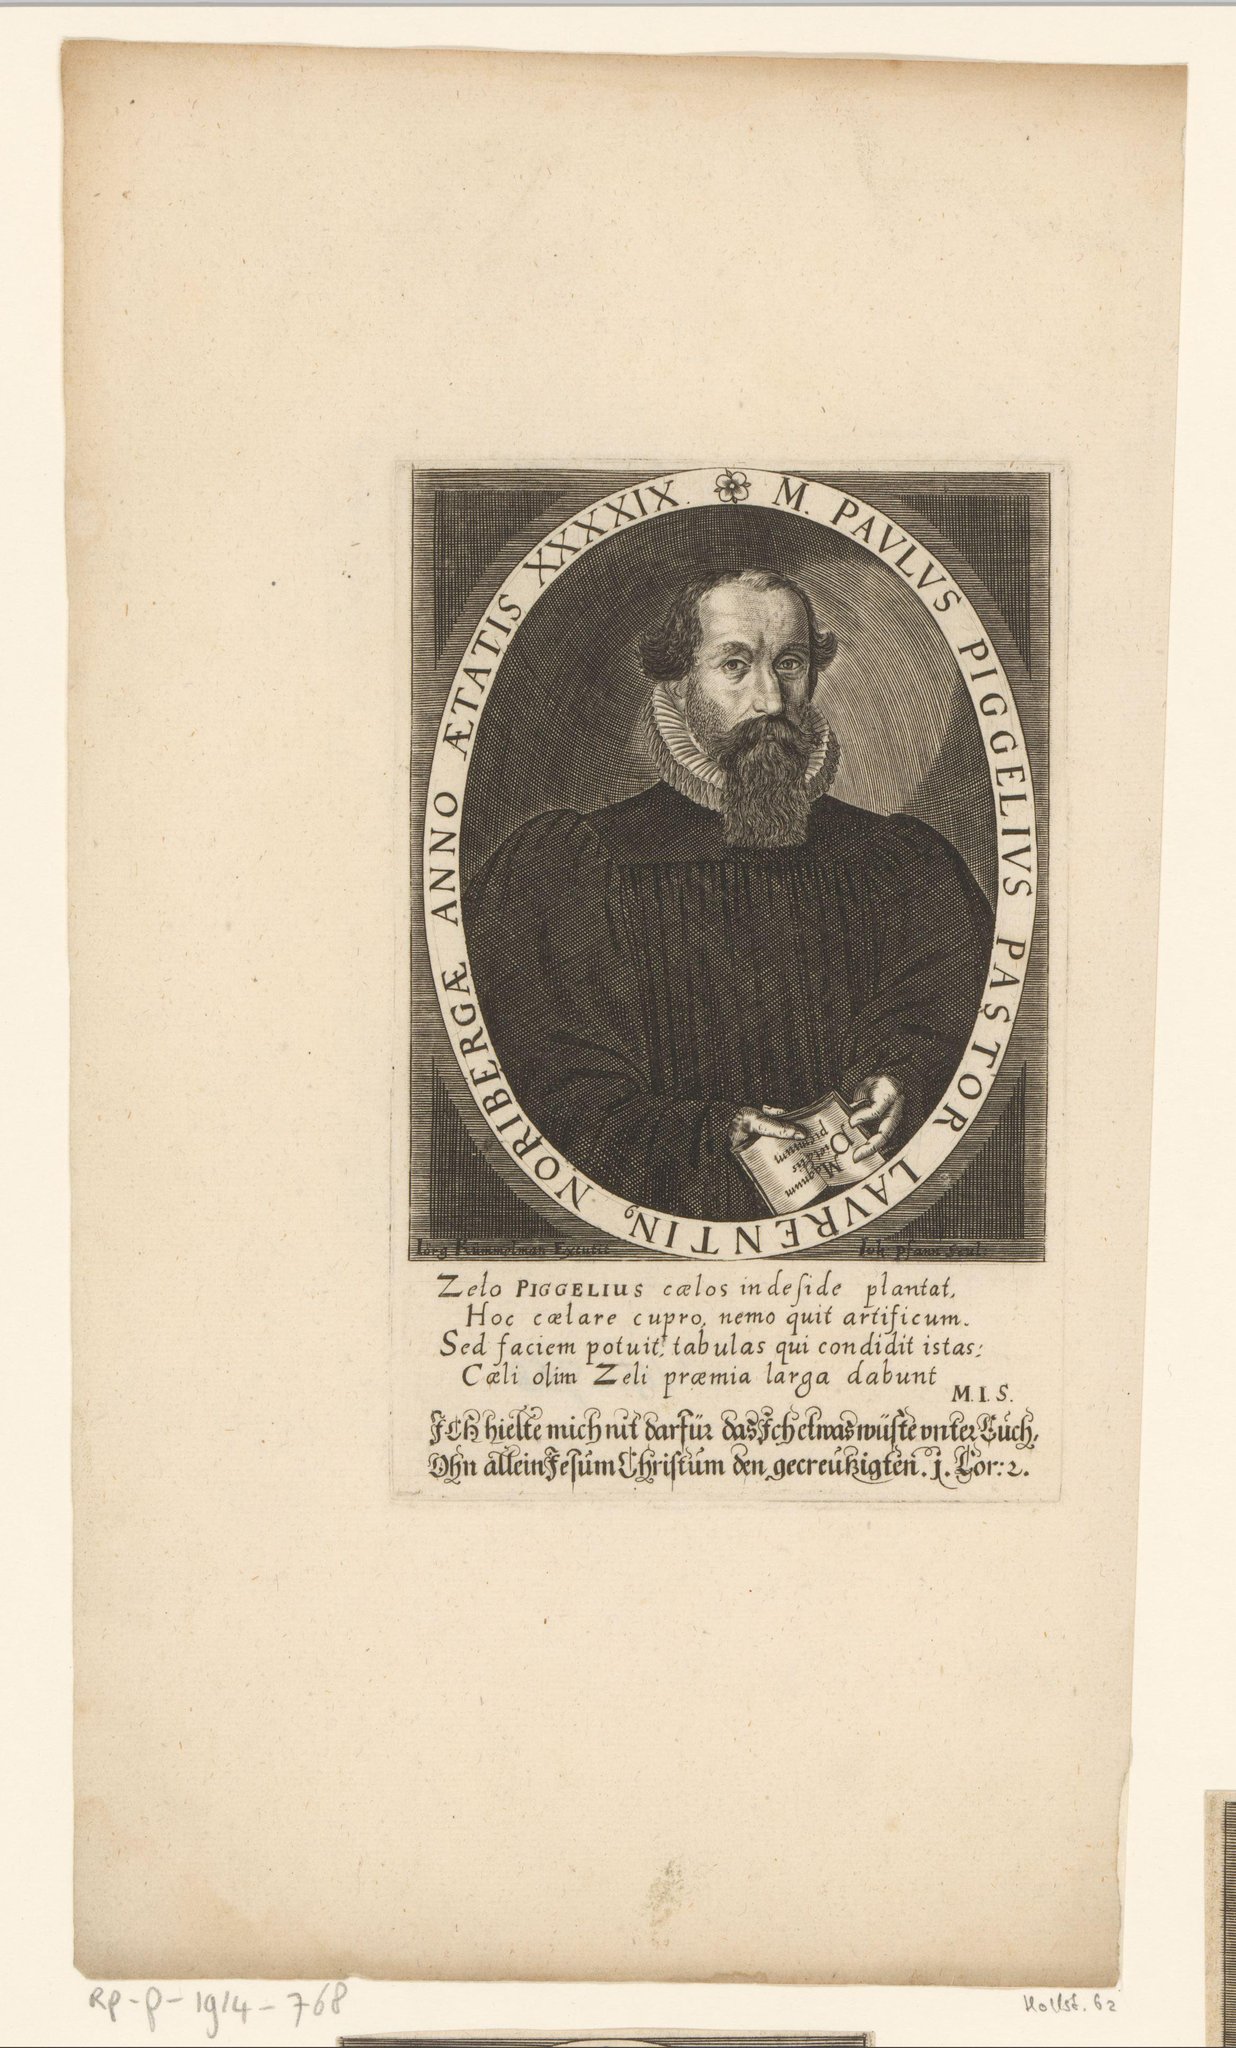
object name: print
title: Portret van Paul Piggel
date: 1648-1663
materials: paper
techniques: engraving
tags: historical persons, book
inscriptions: collector's mark: Lugt 2228